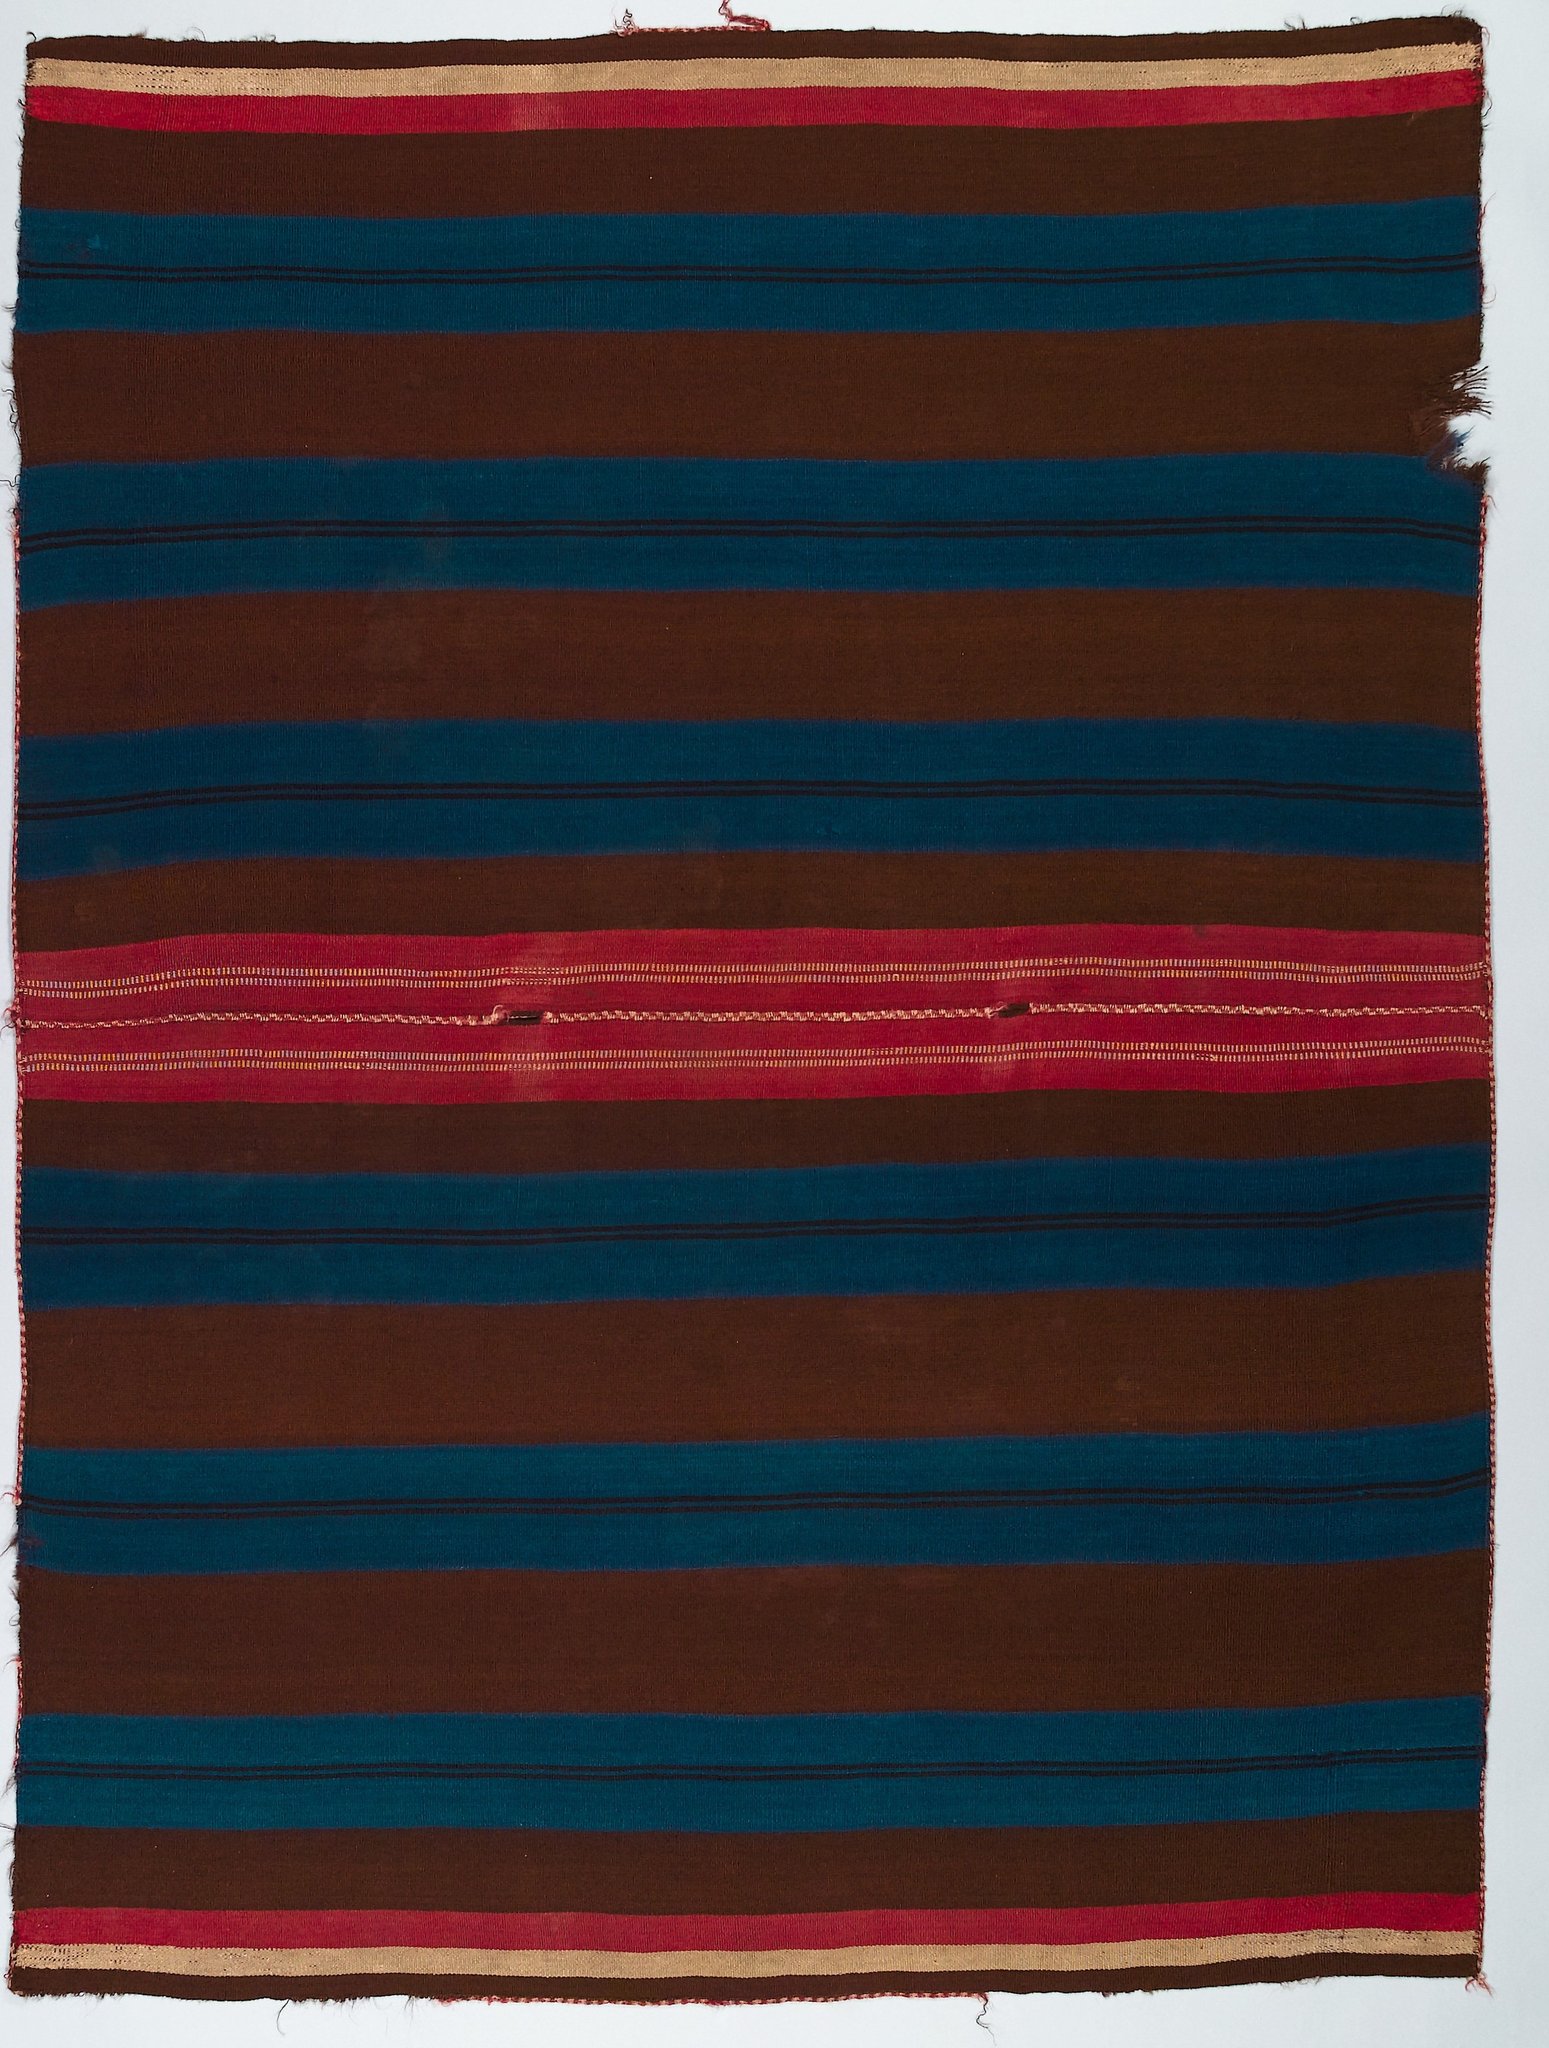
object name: mantle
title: Woman's Mantle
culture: aymara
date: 1701-1800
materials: animal fiber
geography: bolivia